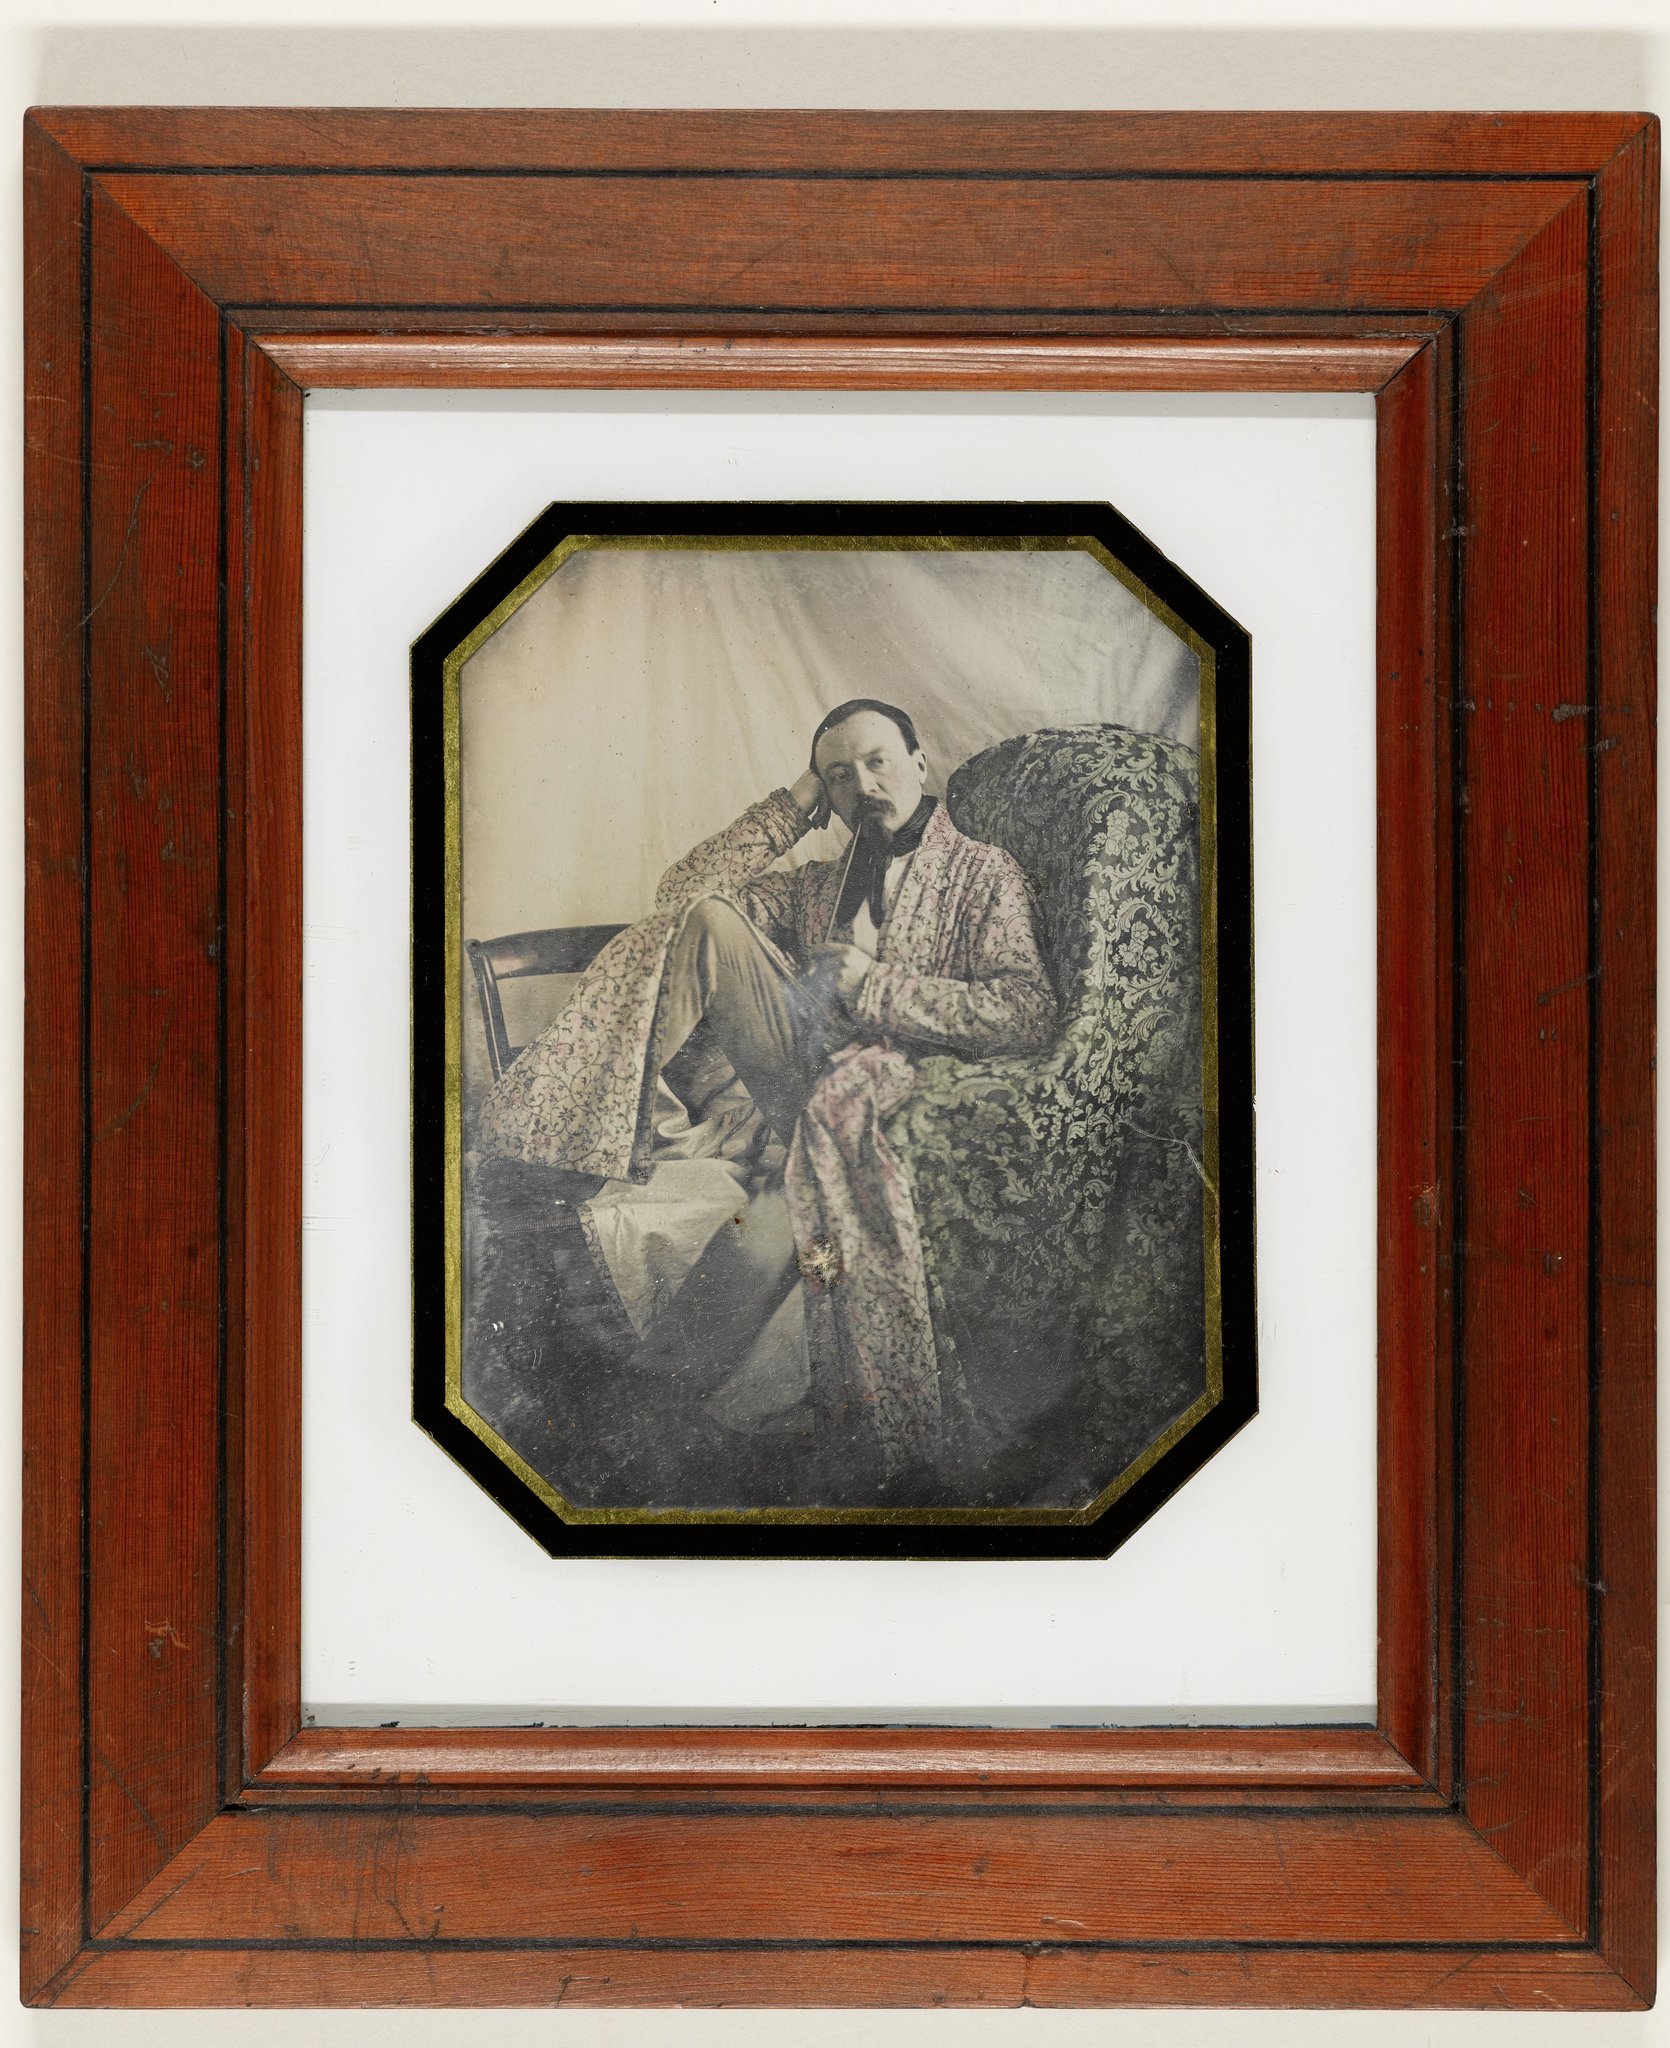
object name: photograph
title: Portrait of a Man in a Dressing Gown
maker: Anonymous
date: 1850-1860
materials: copper, glass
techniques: daguerreotype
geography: france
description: The sitter, wearing a patterned pink dressing gown, sprawls unabashedly in a green velvet armchair. He smokes a pipe and gazes out confidently at the photographer. This is not a portrait of a spouse or a loved one, but rather an apt characterization of a dandy, exactly as found in caricatures or fashion prints. The gold border is the perfect finishing touch.